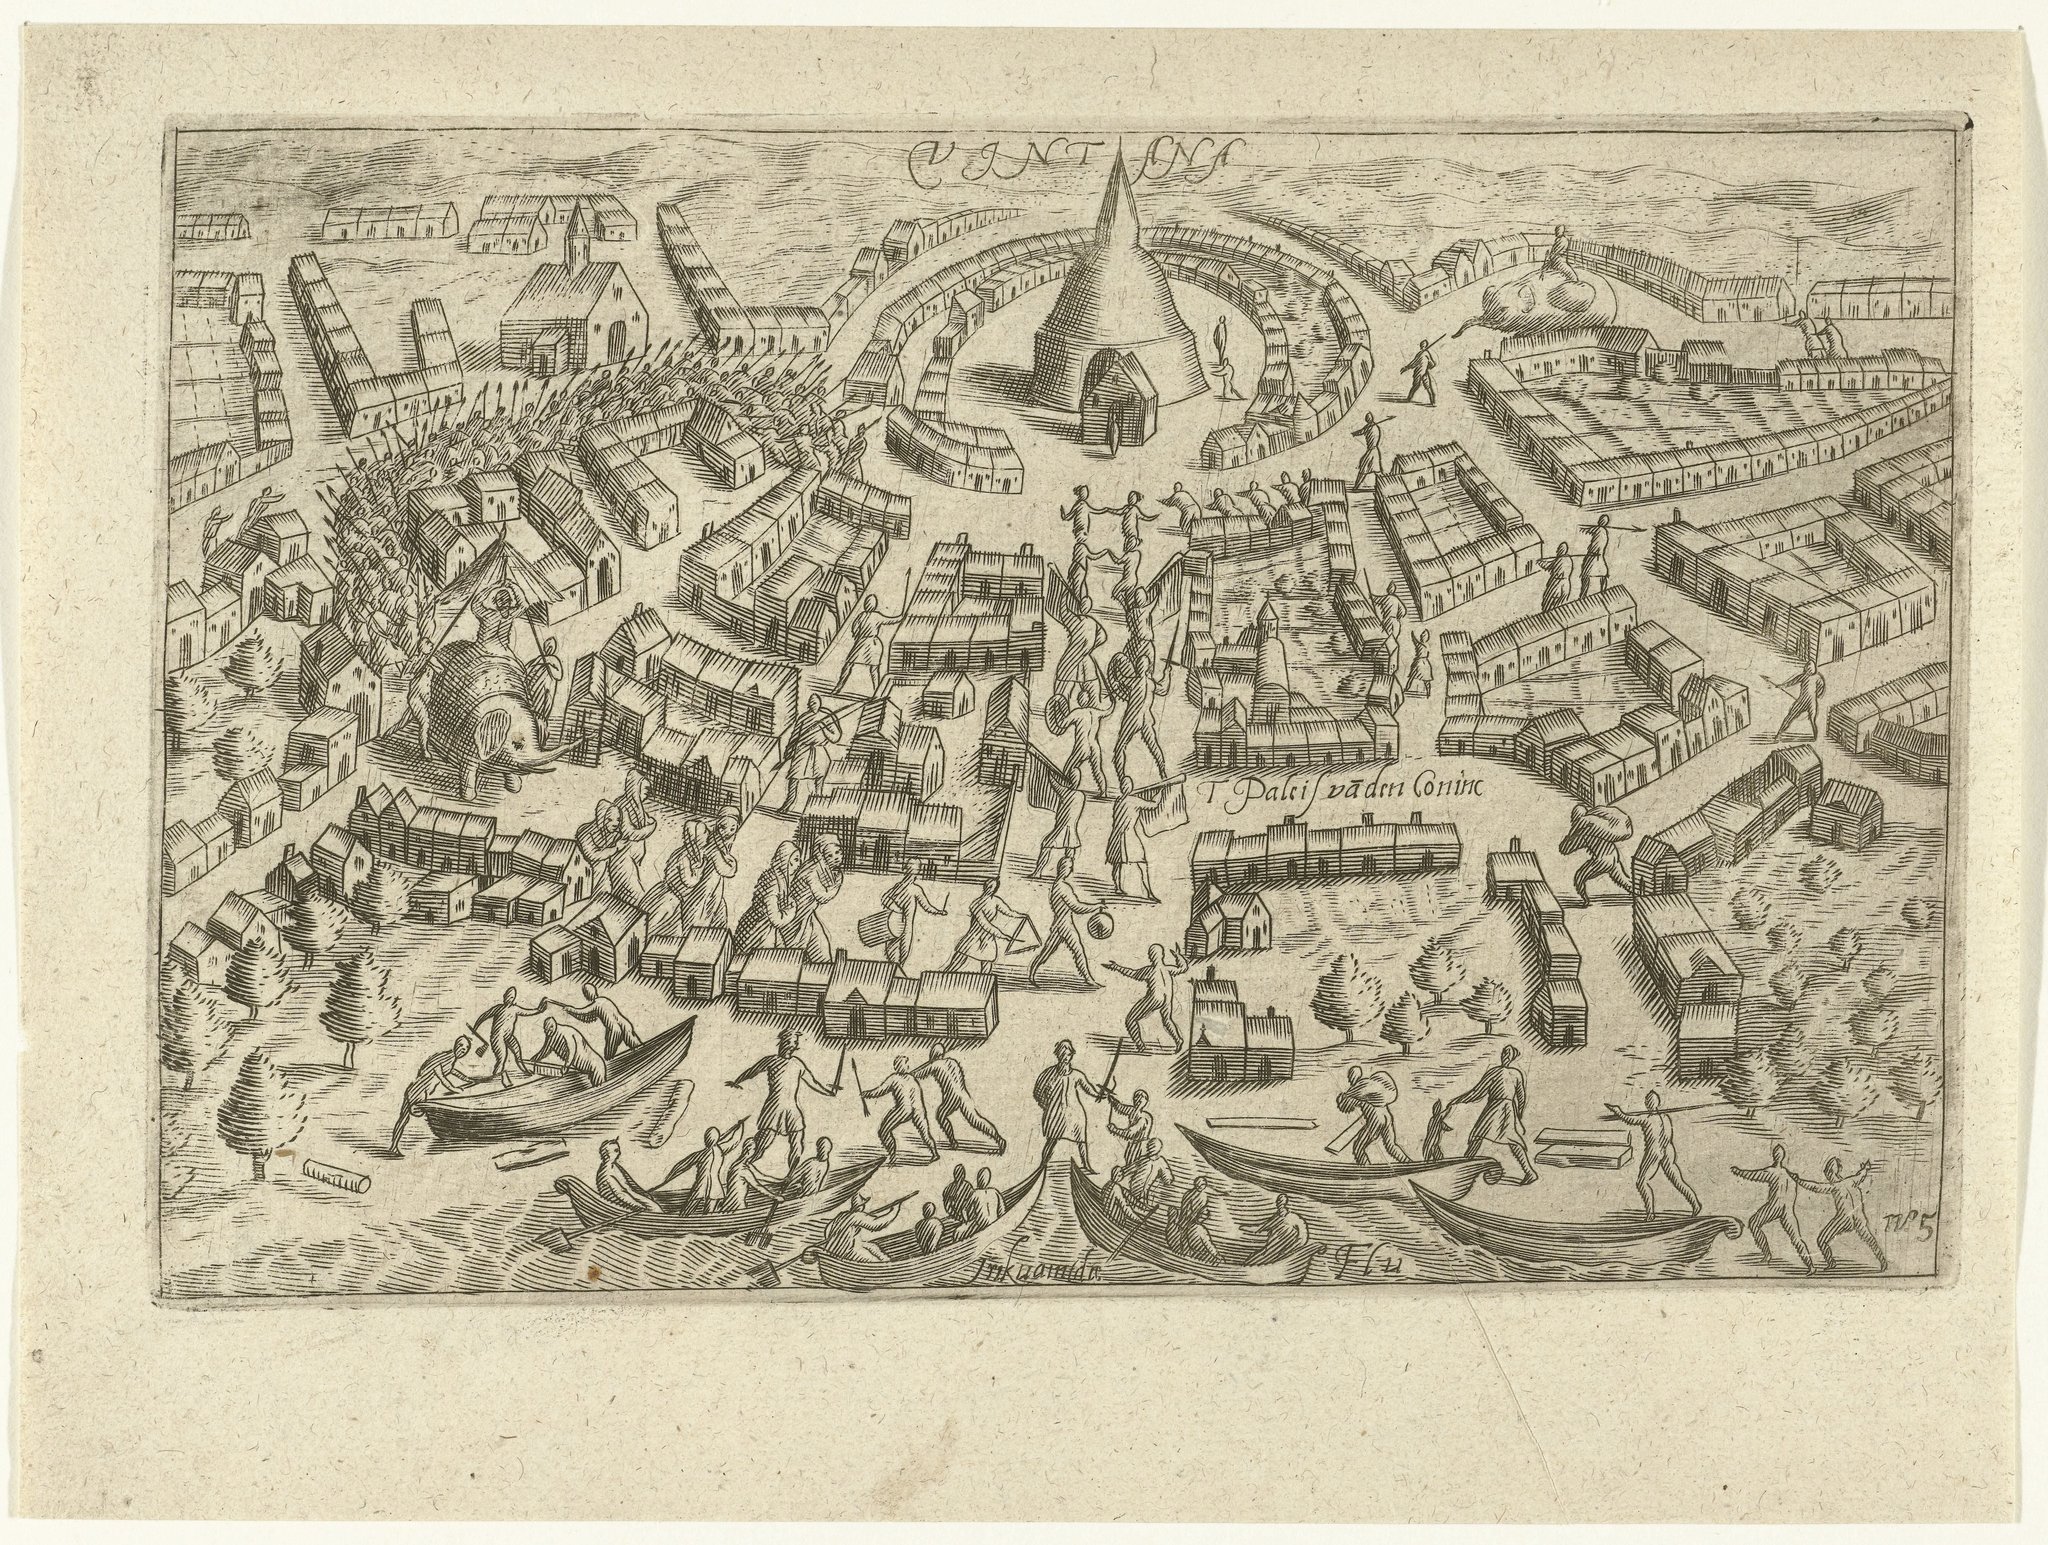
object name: print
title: Bezoek aan de stad Vintana op Ceylon, 1602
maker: Anonymous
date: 1644-1646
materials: paper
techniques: engraving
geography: northern netherlands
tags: antwerp, bergen op zoom, landscapes in tropical and sub-tropical regions, exploration, expedition, voyage of discovery, sri lanka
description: De oorspronkelijke plaat gebruikt als illustratie eerst in: J. van Spilbergen, t'Historiael iournael, van tghene ghepasseert is van weghen drie schepen (...) onder tbeleyt van Ioris van Speilberghen generael, anno 1601 (...) tot in t'eylant Celon, Floris Balthasars, Delft, 1605. Deze kopie gebruikt als illustratie in: 't Historiael Journael, van tghene ghepasseert is van weghen drie Schepen ghenaemt den Ram, Schaep, ende het lam, ghevaren uyt Zeelandt, van der Stadt Camp-Vere, naer d'Oost-Indien, onder 't beleyt van den heer Admirael Joris van Splibergen, gedaen in de Jaren 1601. 1602. 1603. ende 1604. Opgenomen in: I. Commelin, Begin ende voortgangh, van de Vereenighde Nederlantsche Geoctroyeerde Oost-Indische Compagnie, J. Janssonius, Amsterdam 1646. Genummerd: No. 5.